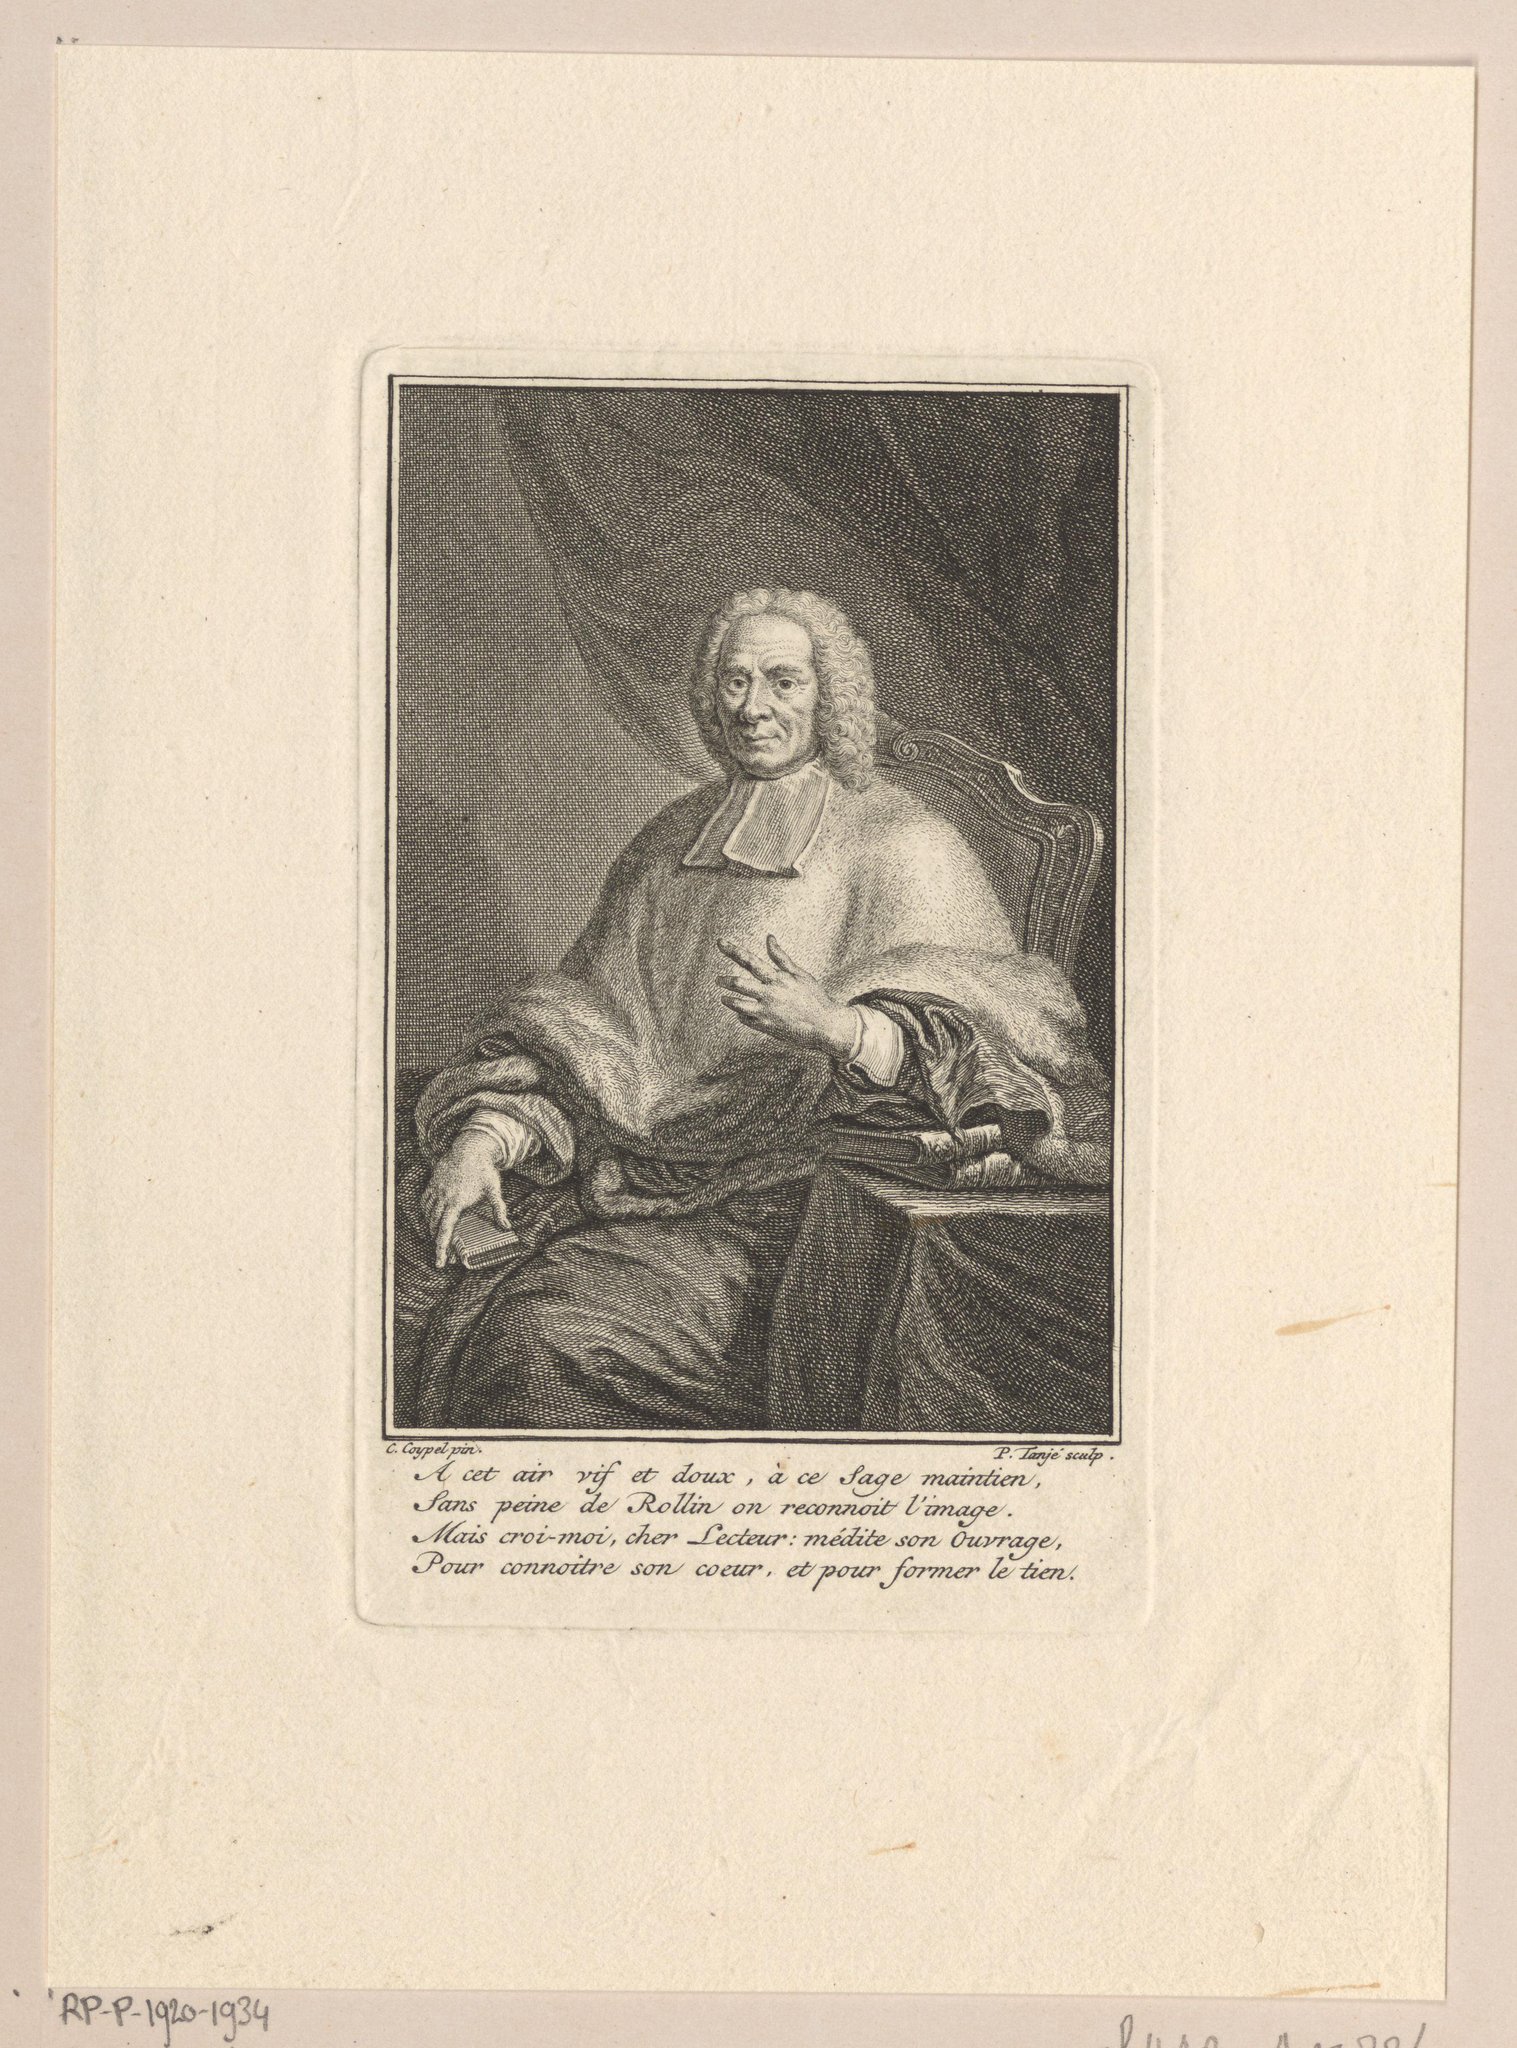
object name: print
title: Portret van Charles Rollin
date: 1716-1761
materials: paper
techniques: etching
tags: paris, charles rollin, historical persons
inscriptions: collector's mark: Lugt 2228